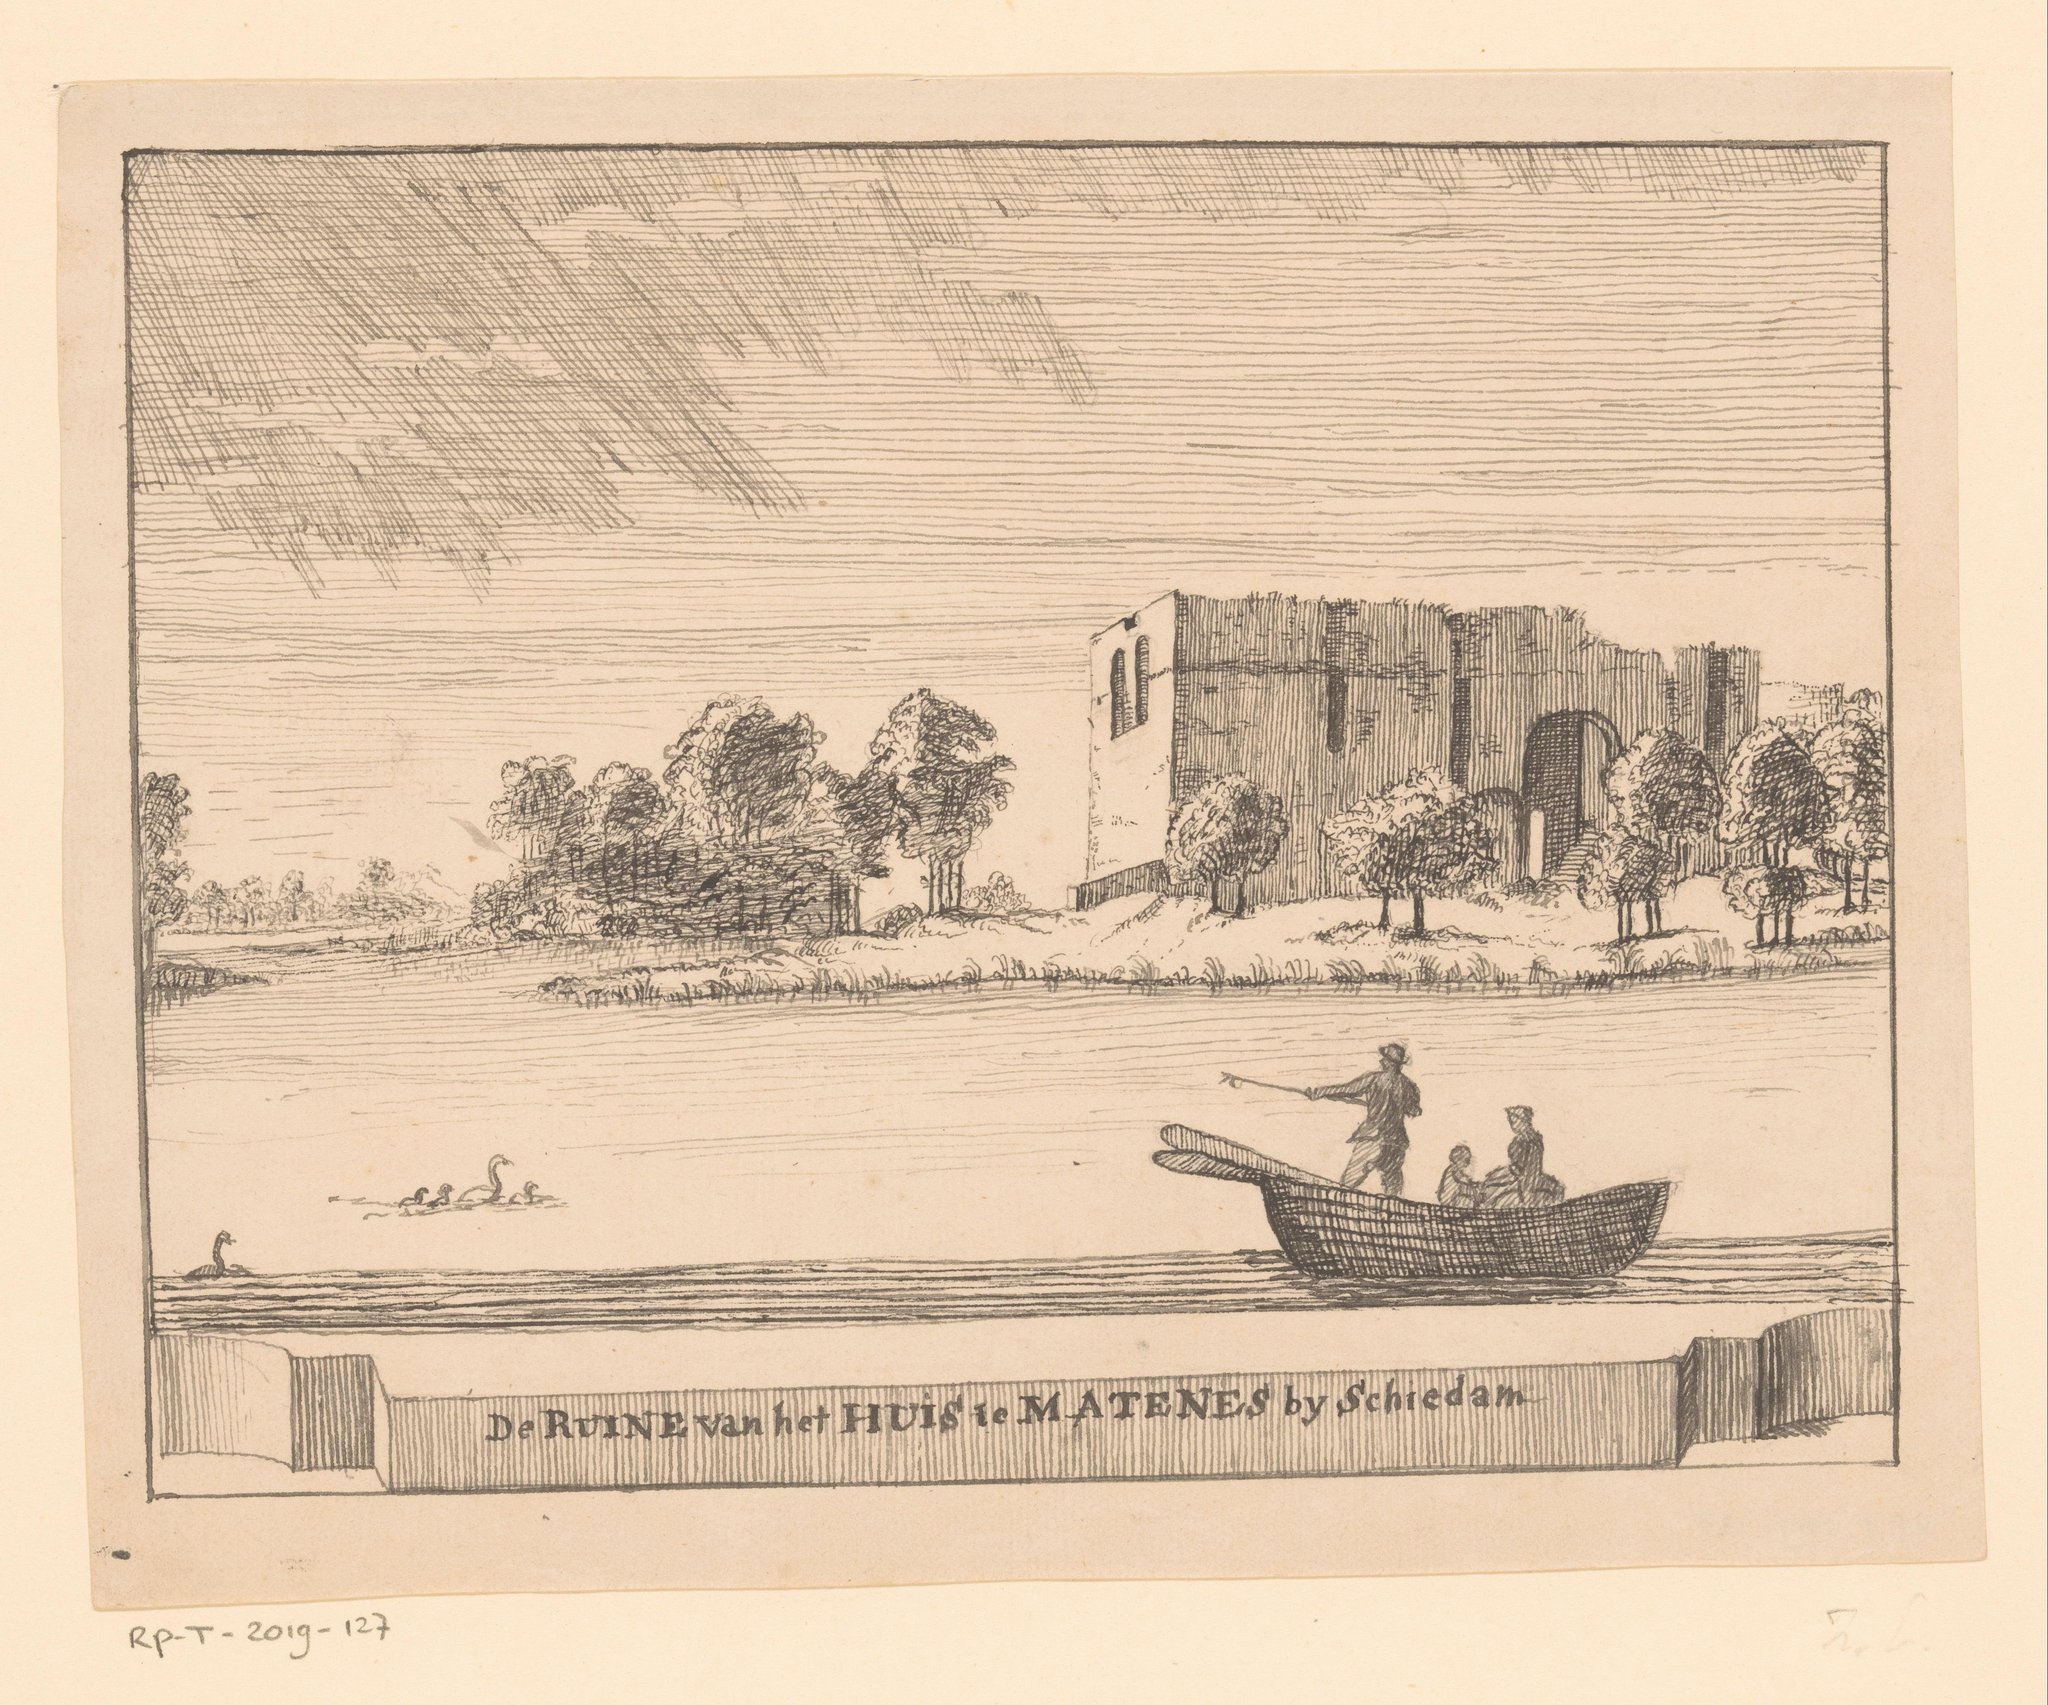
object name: drawing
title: De ruïne van het huis te Matenes by Schiedam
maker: Anonymous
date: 1750-1800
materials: ink, paper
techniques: brush, pen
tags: ruin of a dwelling, house, castle, etc.